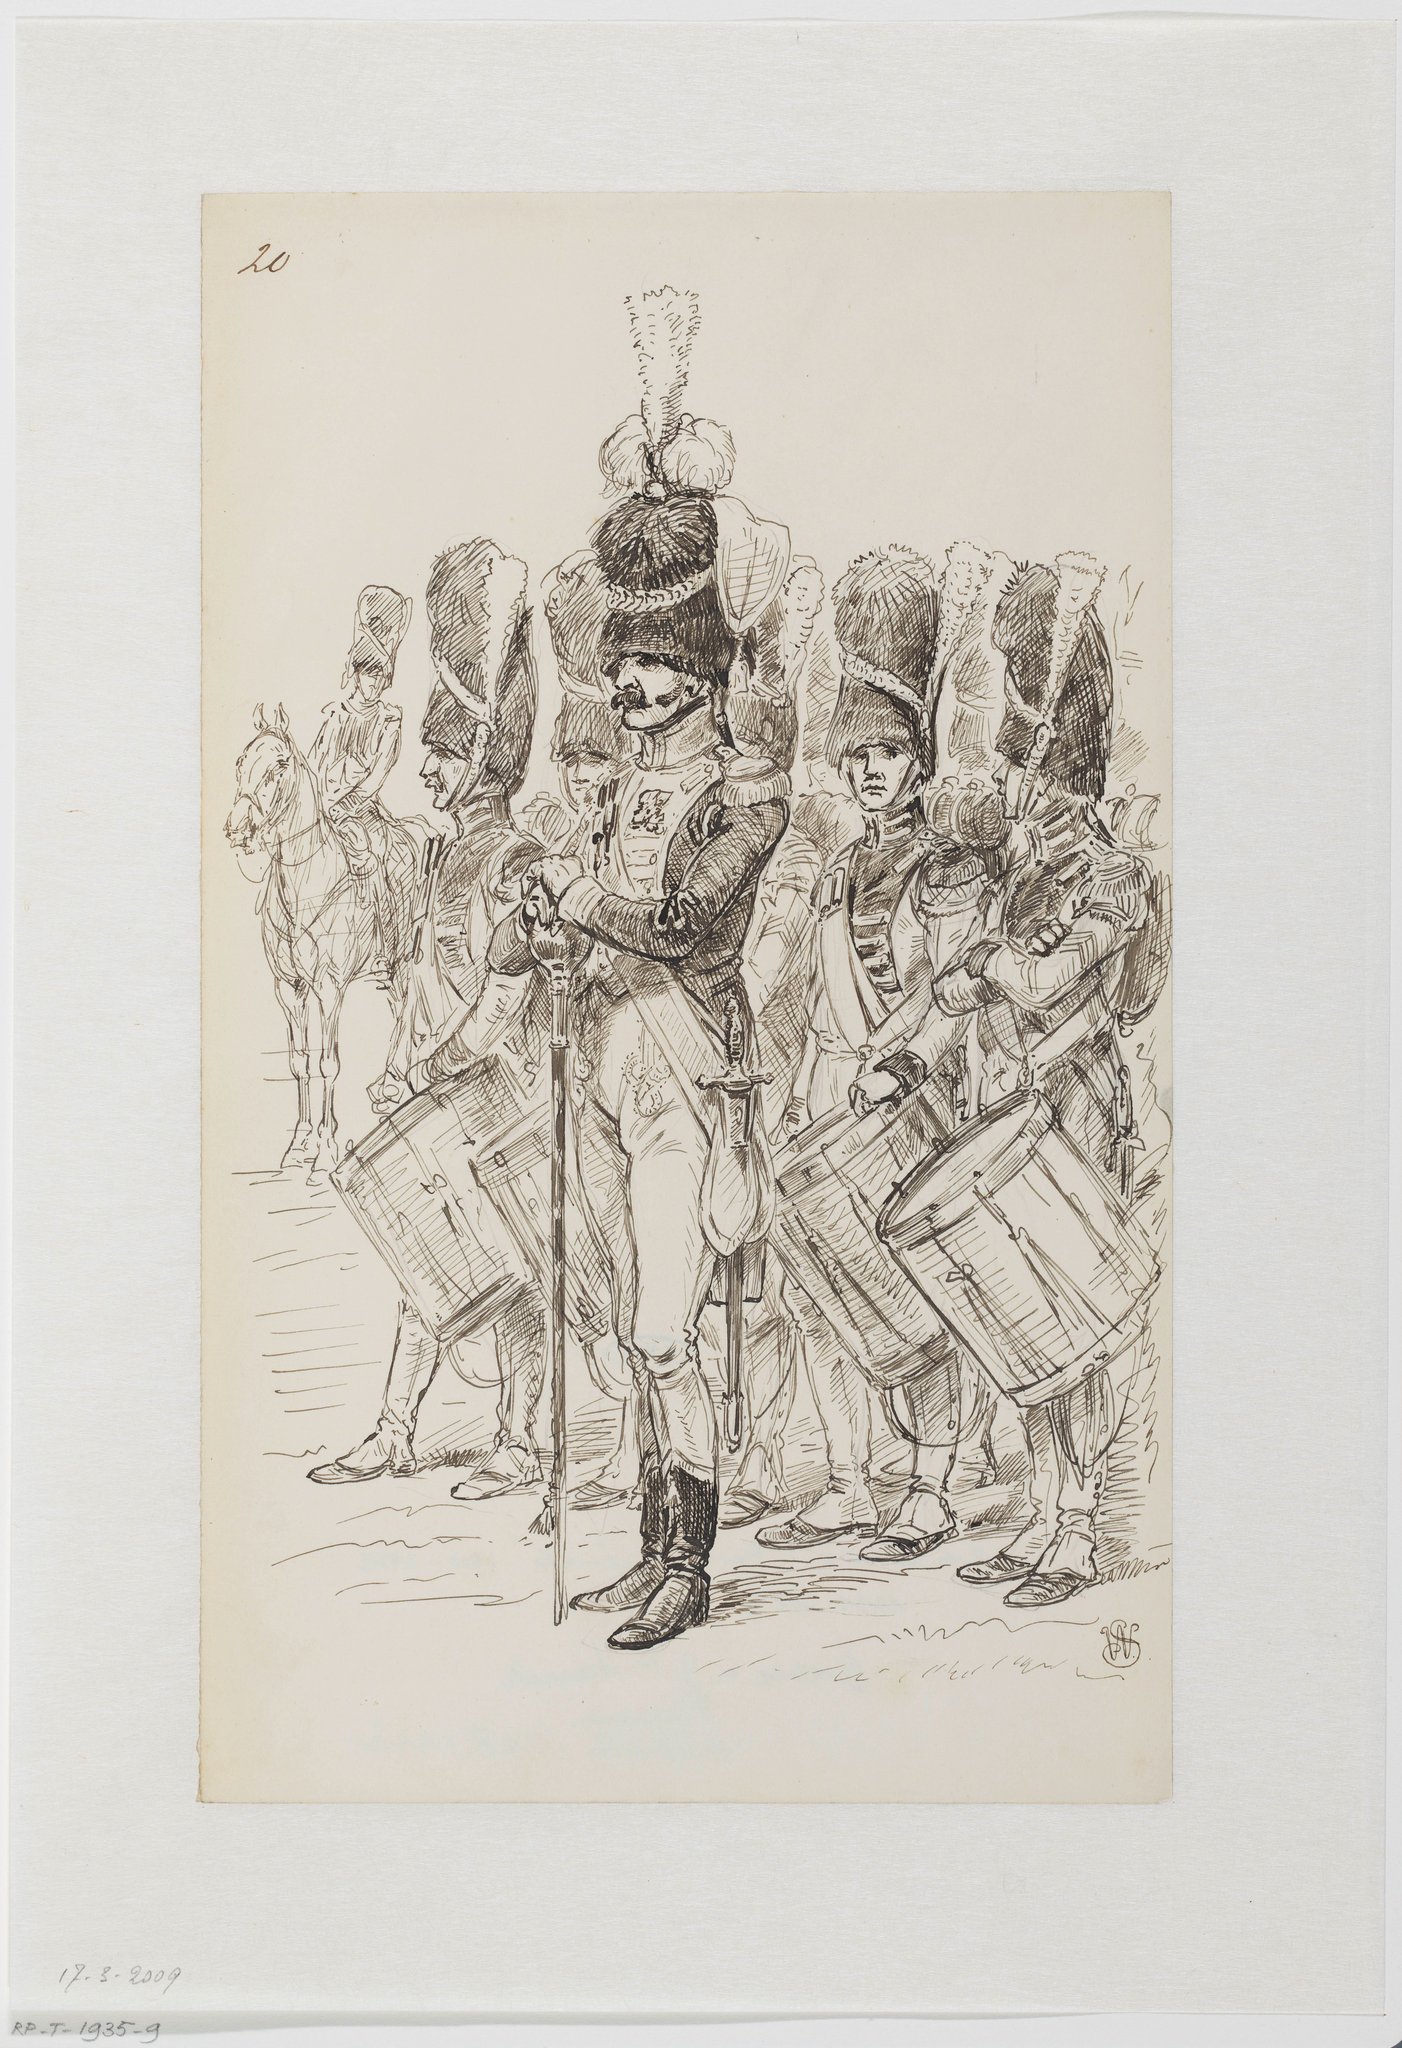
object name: drawing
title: Grenadiers van de Keizerlijke Garde met trommelaars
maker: willem constantijn staring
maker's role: draughtsman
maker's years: 1847-1916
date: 1857-1916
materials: ink, paper, pencil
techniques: pen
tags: the company, the unit, the troop ~ military service, military music